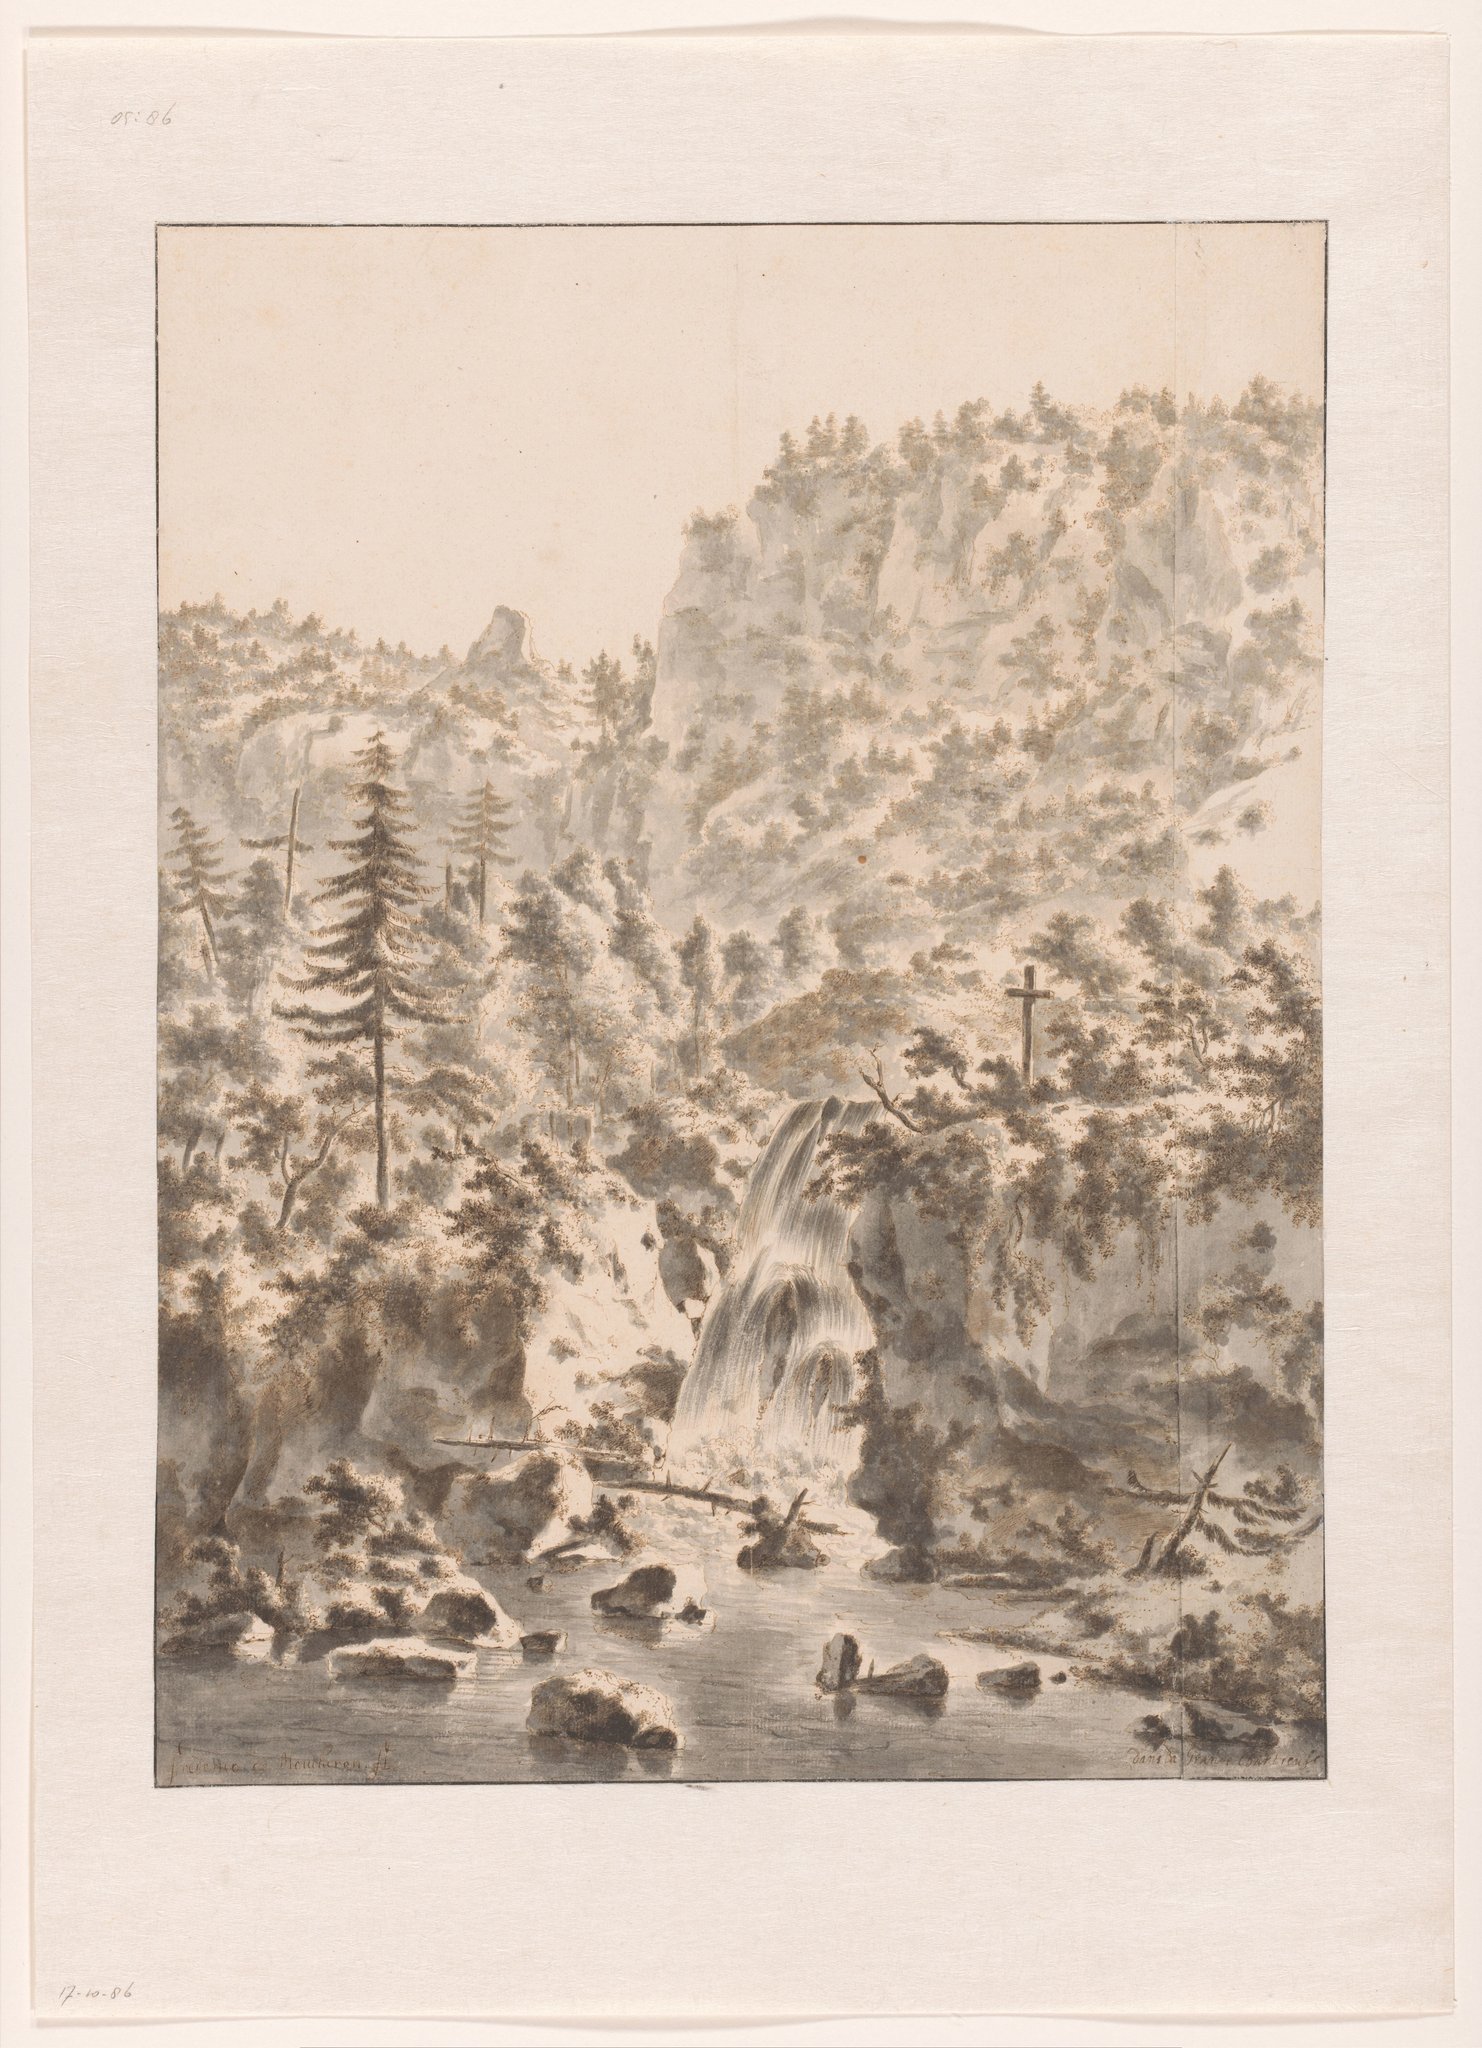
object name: drawing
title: Waterfall in the Chartreuse Mountains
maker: frederik de moucheron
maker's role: draughtsman, painter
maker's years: 1633-1686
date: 1669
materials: chalk, ink, paper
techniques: brush, pen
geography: amsterdam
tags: waterfall, mountains